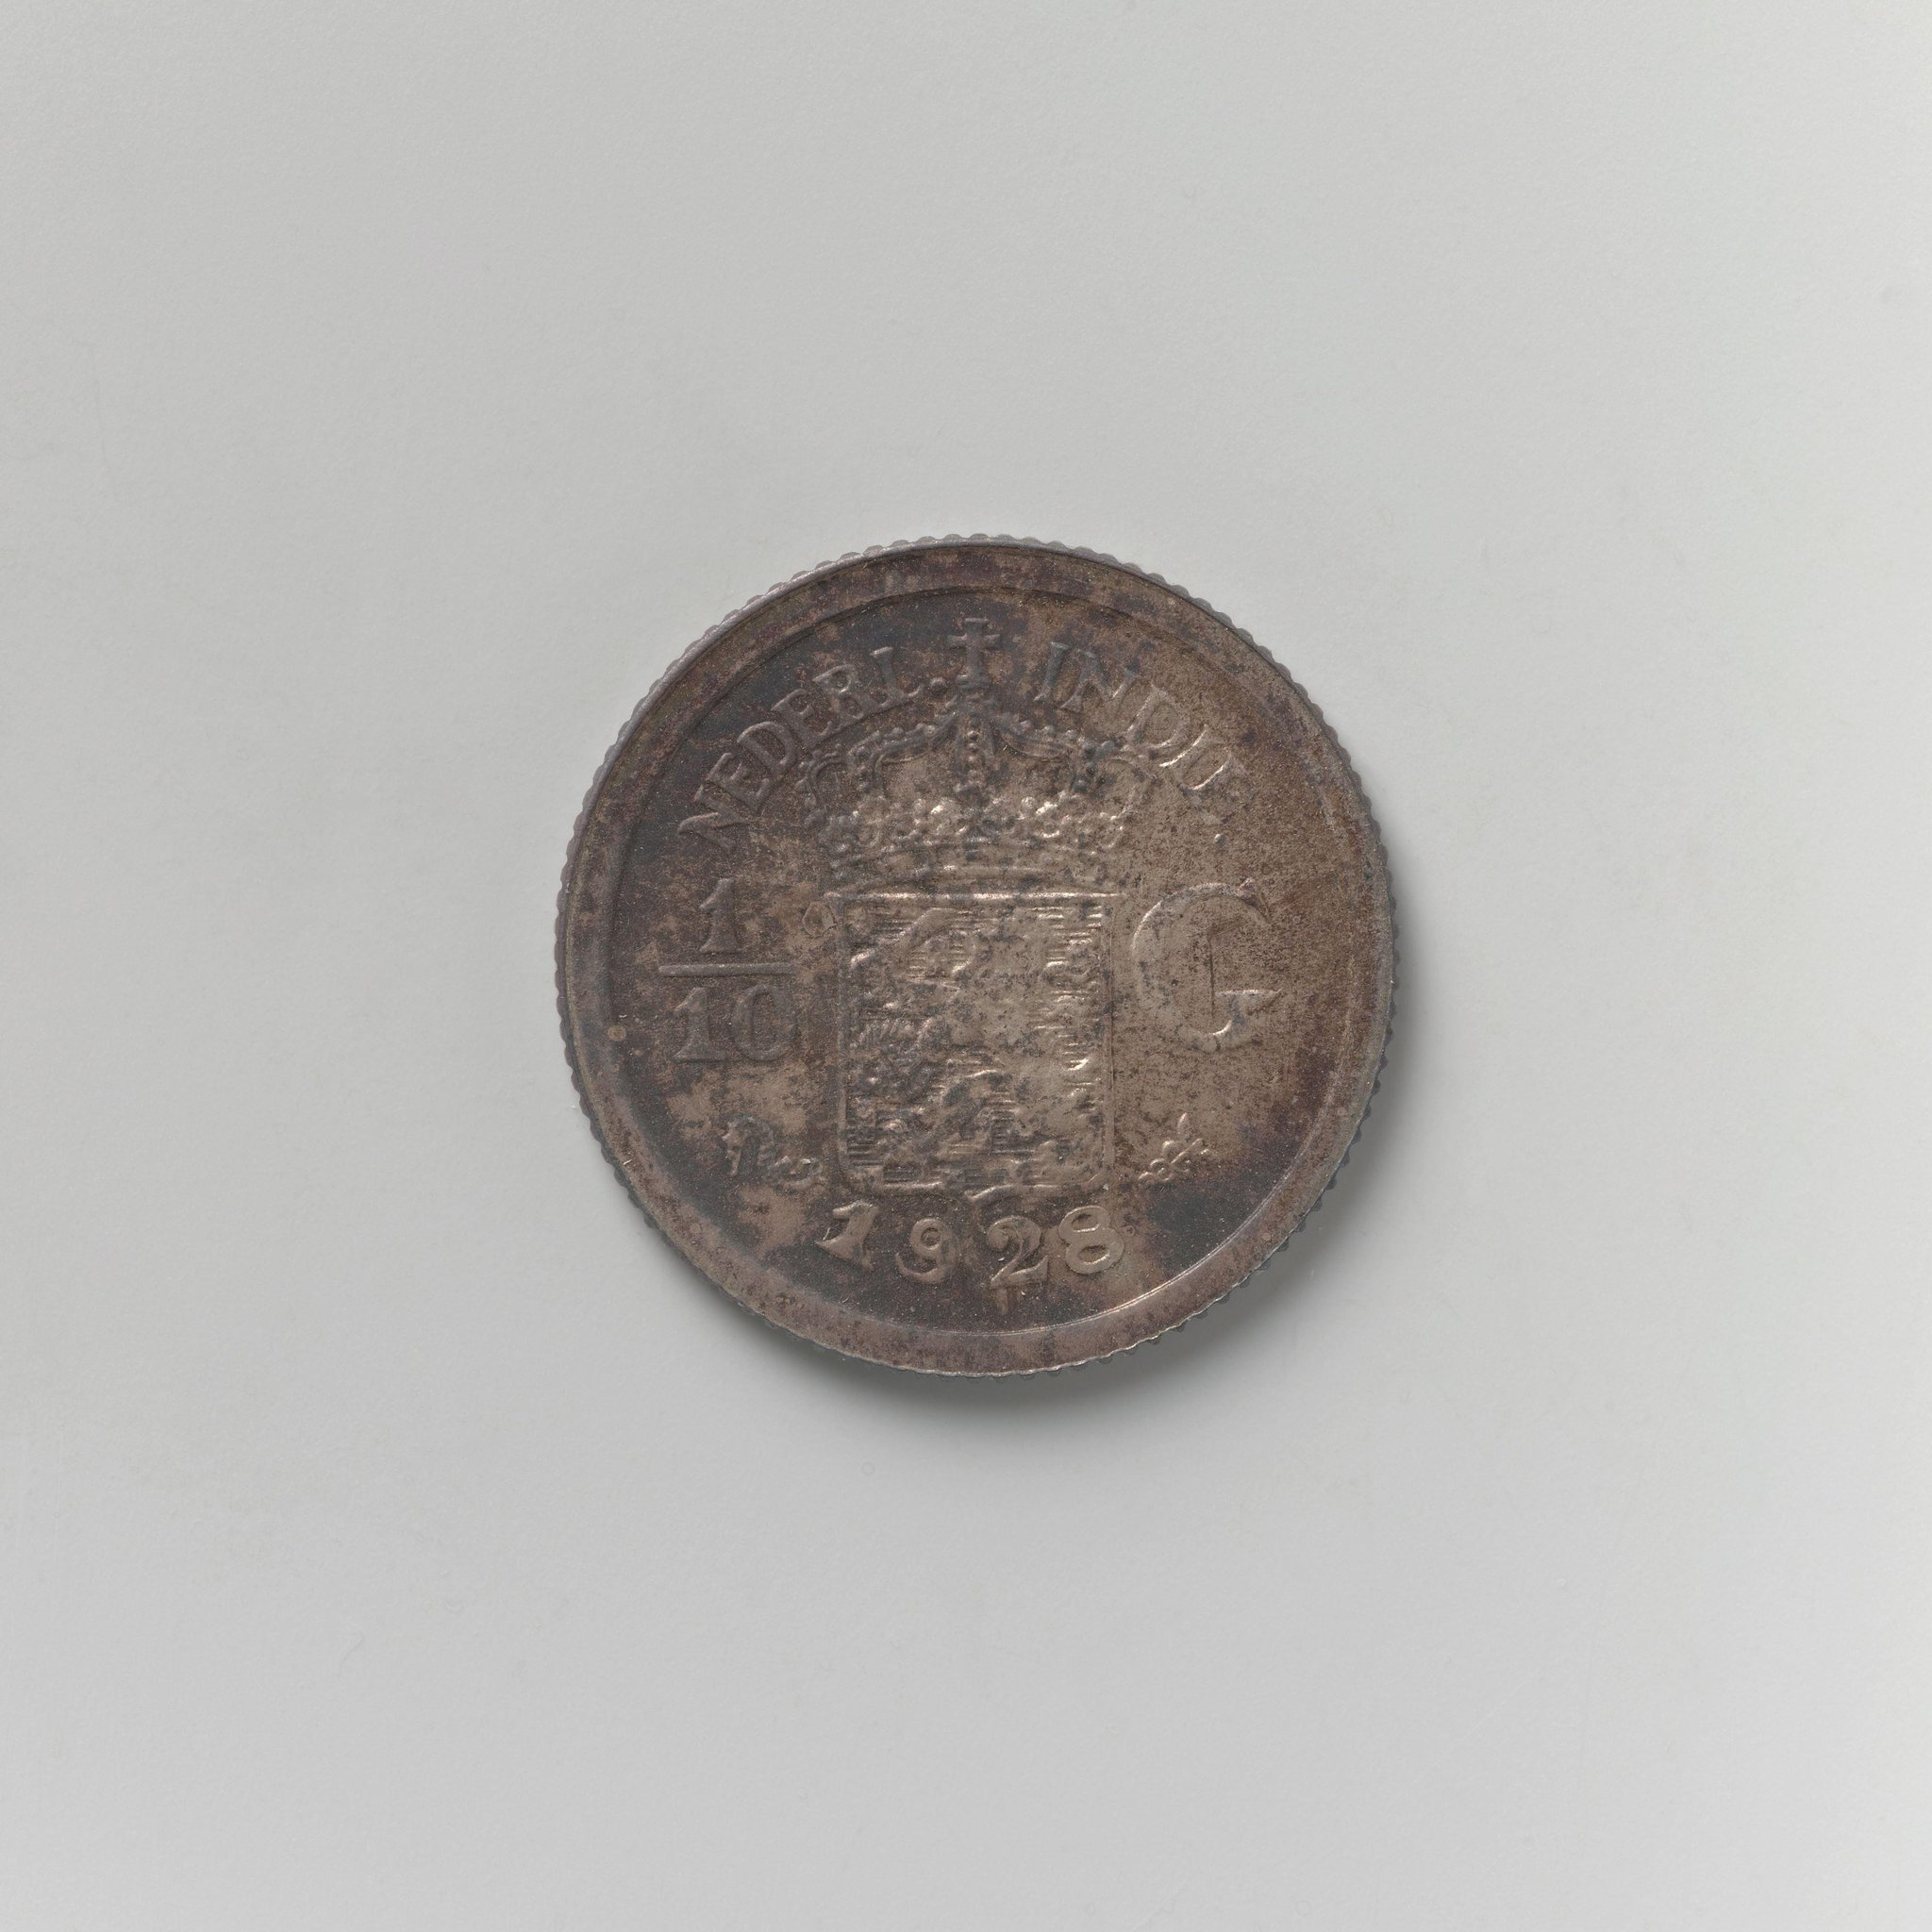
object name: coin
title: Nederlands Indië,1/10 gulden,1928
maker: wilhelmina of the netherlands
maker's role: print maker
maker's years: 1880-1962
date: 1928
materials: copper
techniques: striking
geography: utrecht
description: Zilveren munt. Voorzijde: tussen waarde-aanduiding 1/10 G gekroond rijkswapenschild. Boven kroon landsaanduiding en onder wapenschild jaartal. Keerzijde: tweeregelig Maleis opschrift in Arabische tekens, waaromheen omschrift in het Javaans. Kartelrand.